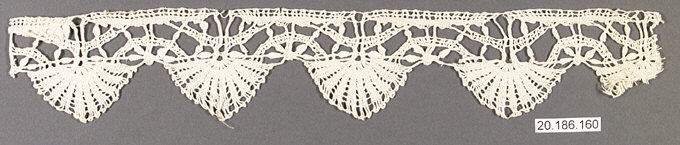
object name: edging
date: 1601-1700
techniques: lace